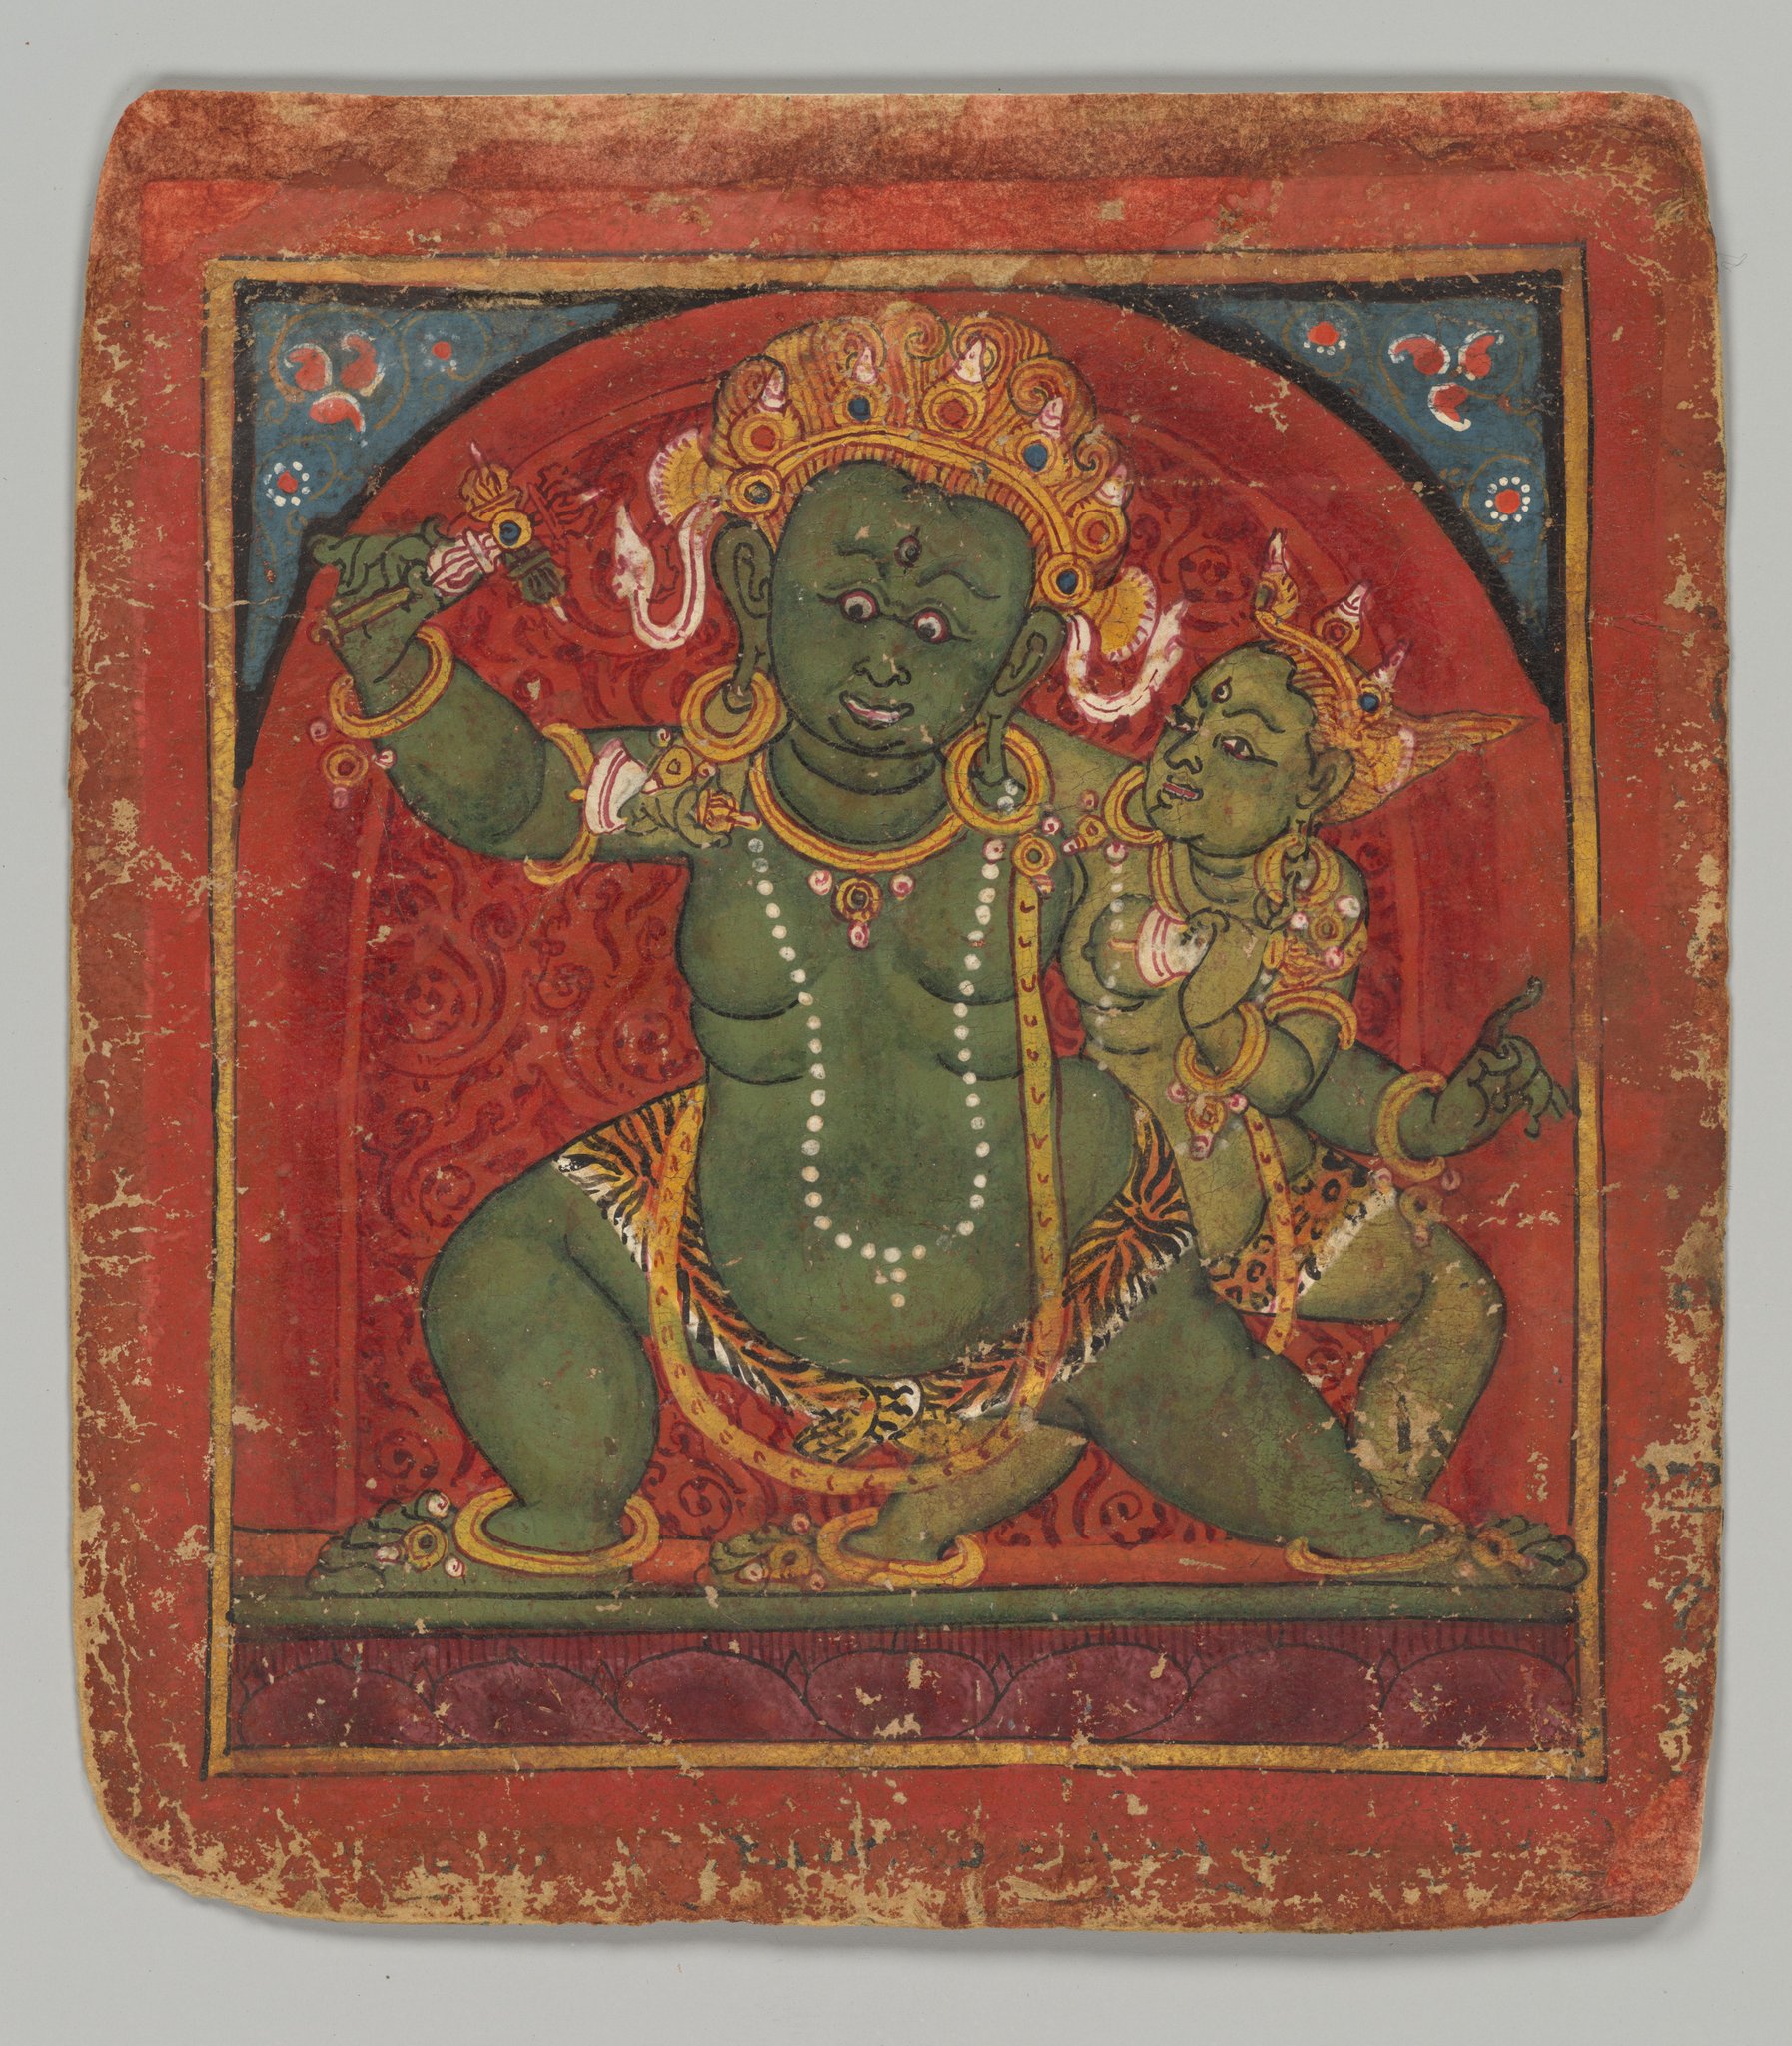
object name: initiation card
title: Initiation Card (Tsakalis): Door Keeper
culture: tibetan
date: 1401-1433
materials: paper, watercolor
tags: buddhism,deities